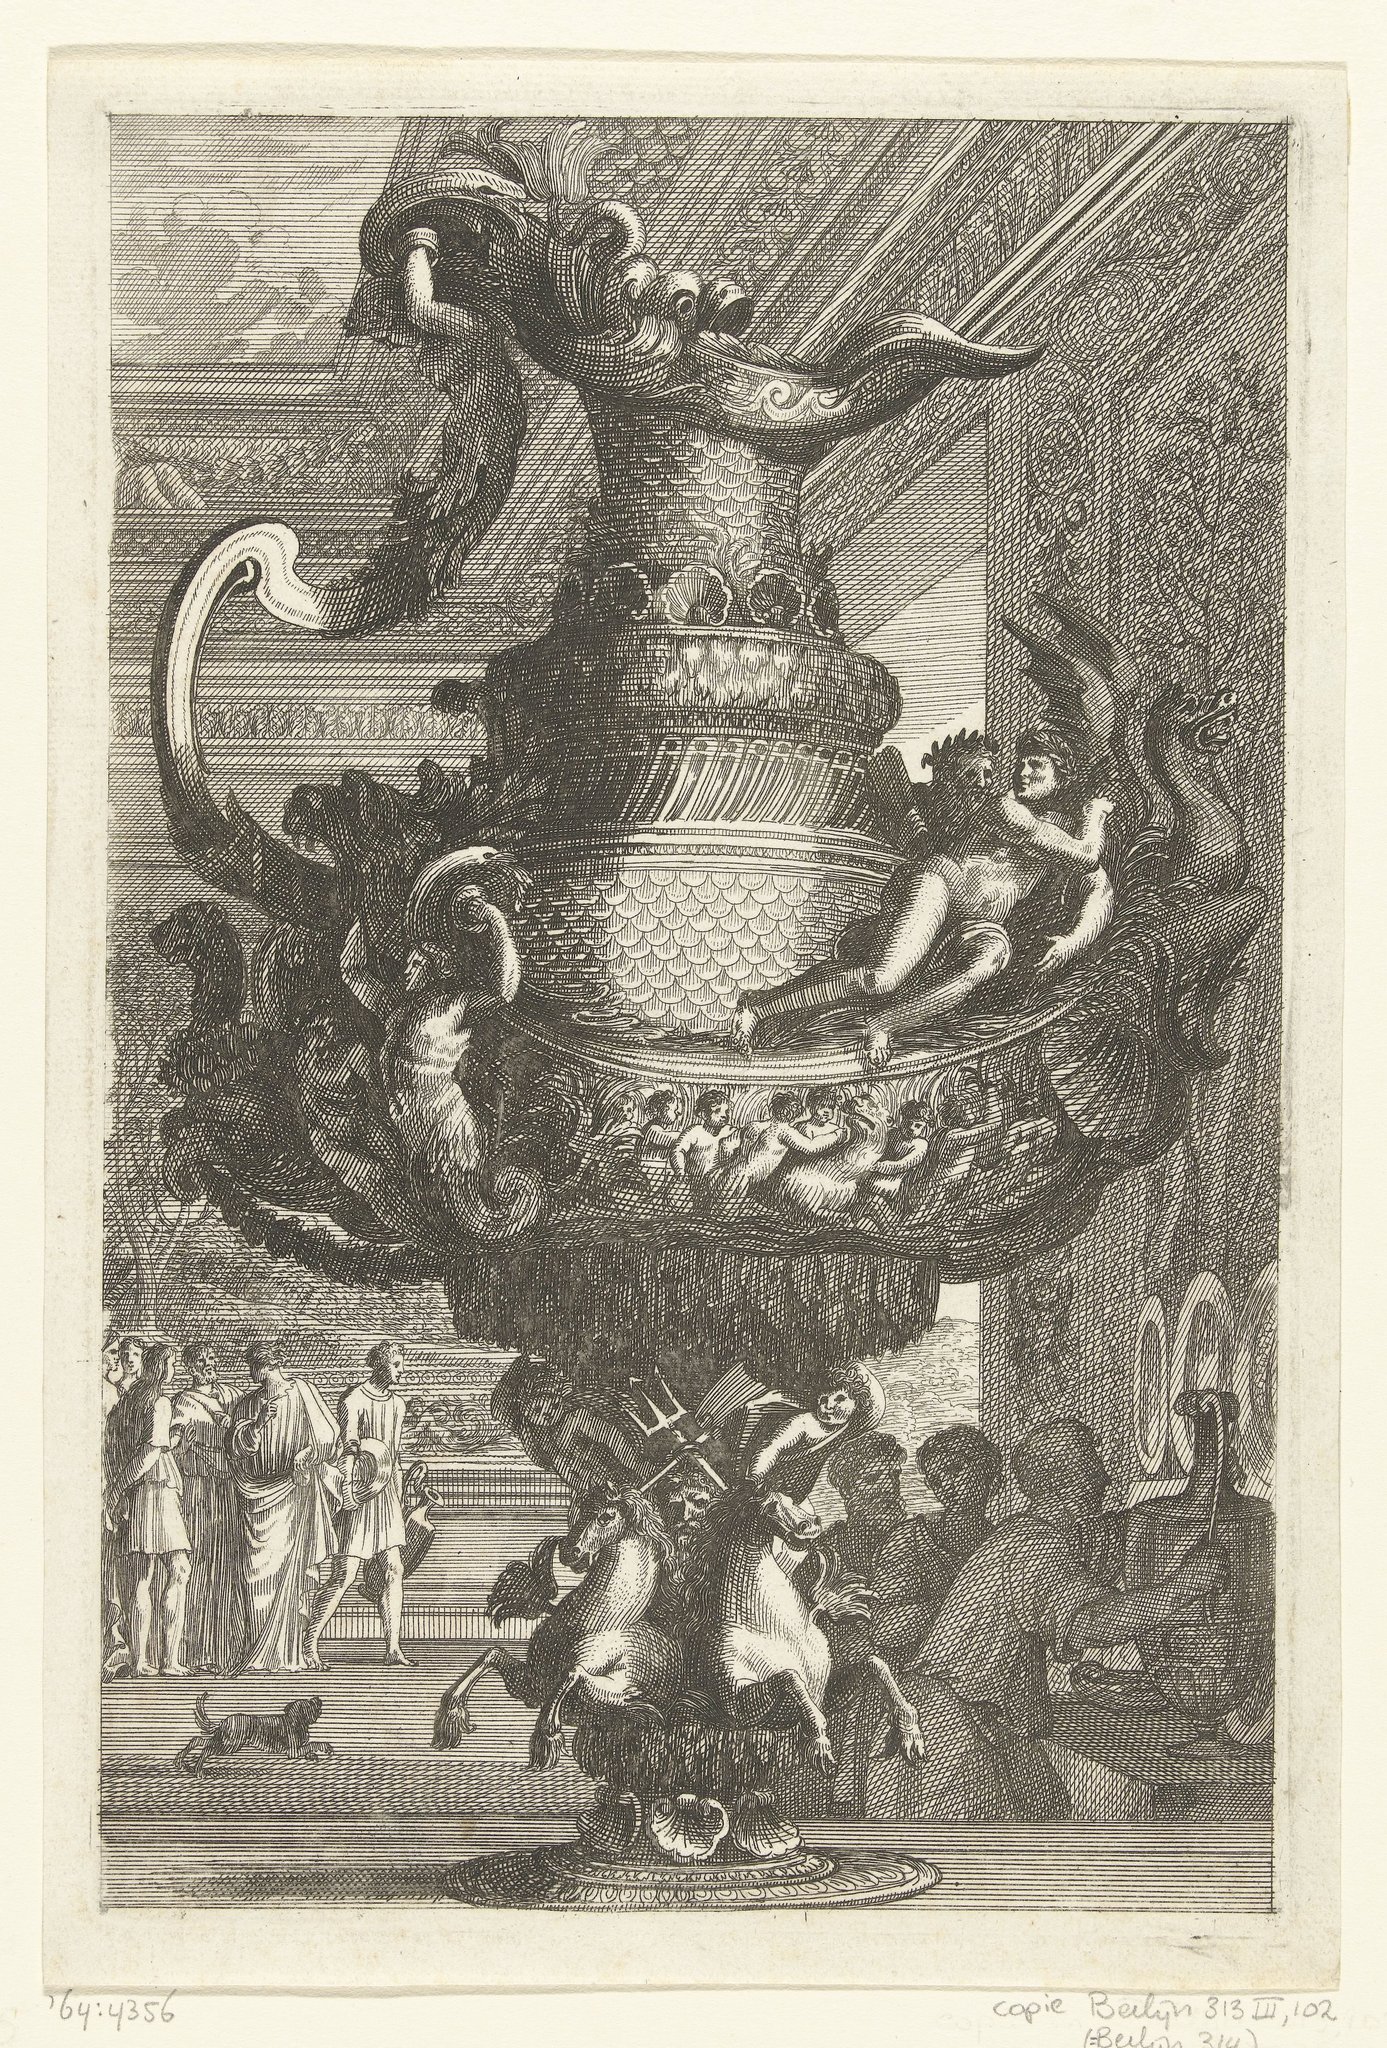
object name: print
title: Schenkkan naar rechts gekeerd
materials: paper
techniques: etching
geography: antwerp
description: De voet van de kan bestaat uit zeepaarden die bereden worden door putti met drietanden.